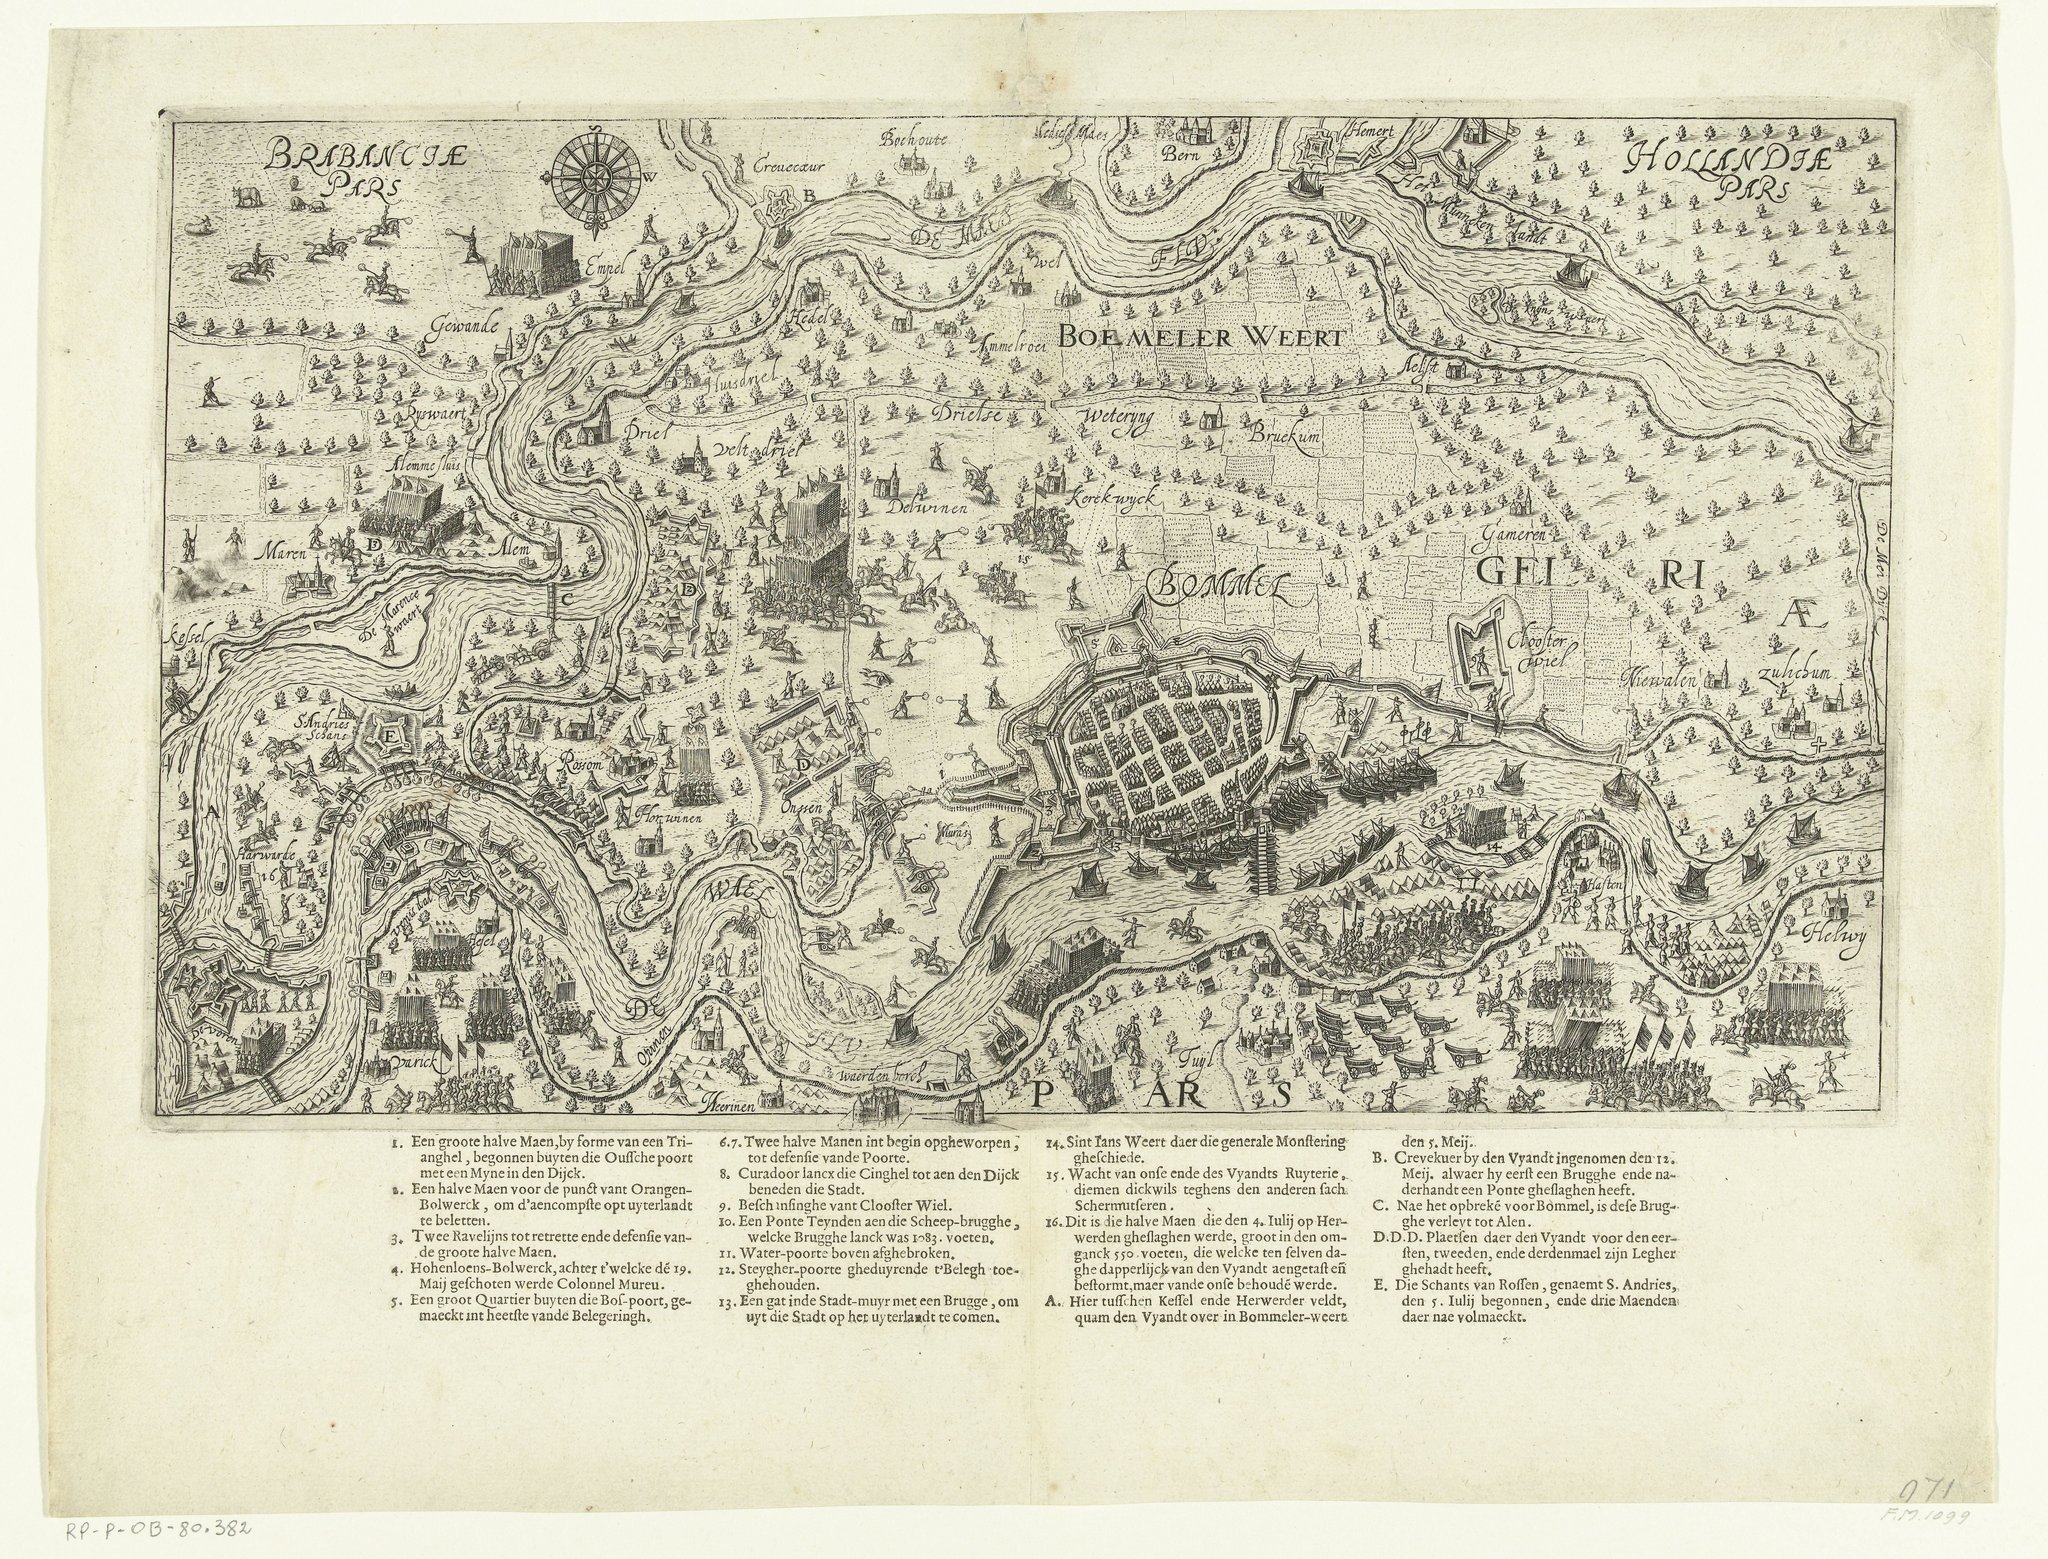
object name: print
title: Belegering van Zaltbommel en andere sterkten in de Bommelerwaard en de bouw van Sint-Andries, 1599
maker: bartholomeus willemsz. dolendo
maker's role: print maker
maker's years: 1560-1626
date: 1600-1601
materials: paper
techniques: engraving, letterpress printing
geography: northern netherlands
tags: the hague, maurice (prince of orange), siege, position war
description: Gebruikt als illustratie in: J.J. Orlers, Den Nassauschen Lauren-Crans: Beschrijvinghe ende af-beeldinge van alle de victorien ... die Godt Almachtich de ... Staten der Vereenichde Nederlanden verleent heeft, deur het wijs ende clouck beleyt des Hooch-ghebooren Fursts Maurits van Nassau, J.J. Orlers en H. van Haestens, Leiden 1610, fol. 144/145.